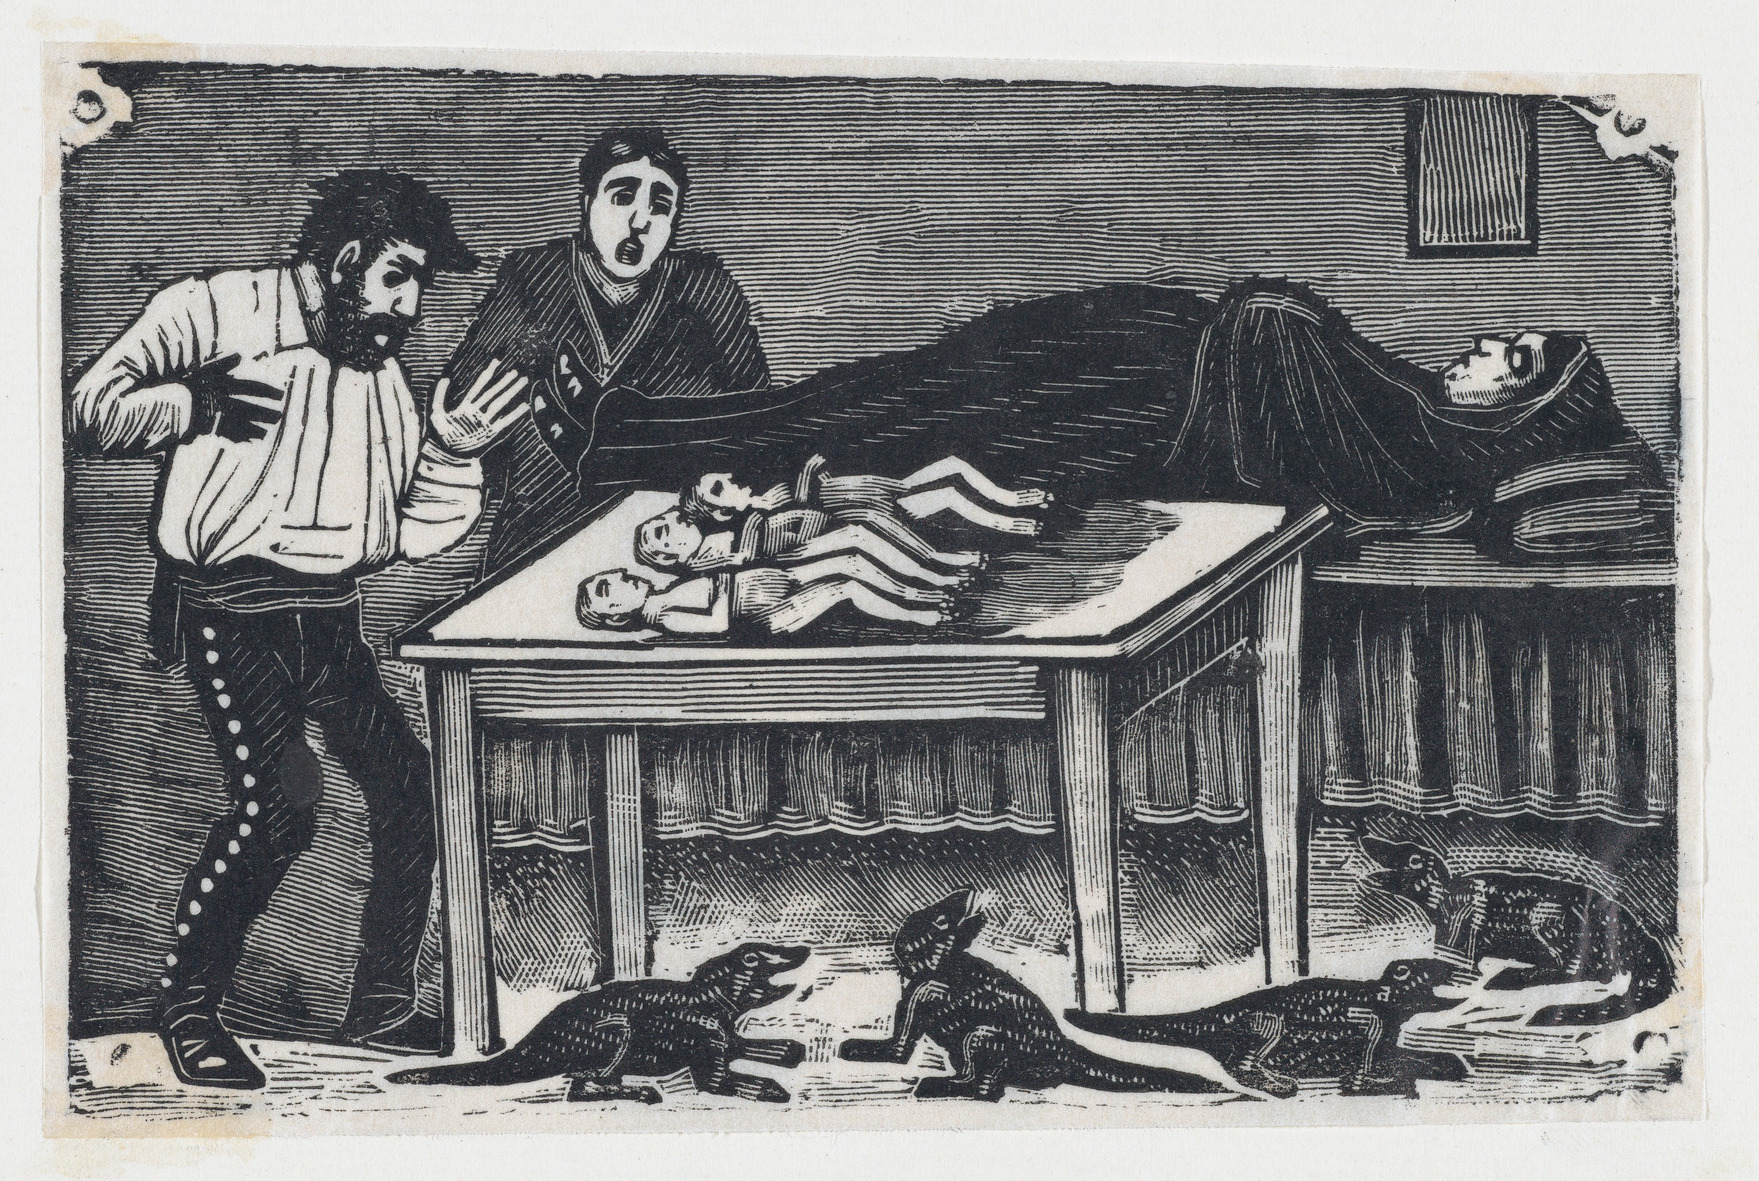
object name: print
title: A woman who gave birth to three children and four animals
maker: josé guadalupe posada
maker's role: artist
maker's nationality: mexican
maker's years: 1852-1913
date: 1894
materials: metal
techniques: engraving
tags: animals,infants,men,women,birth